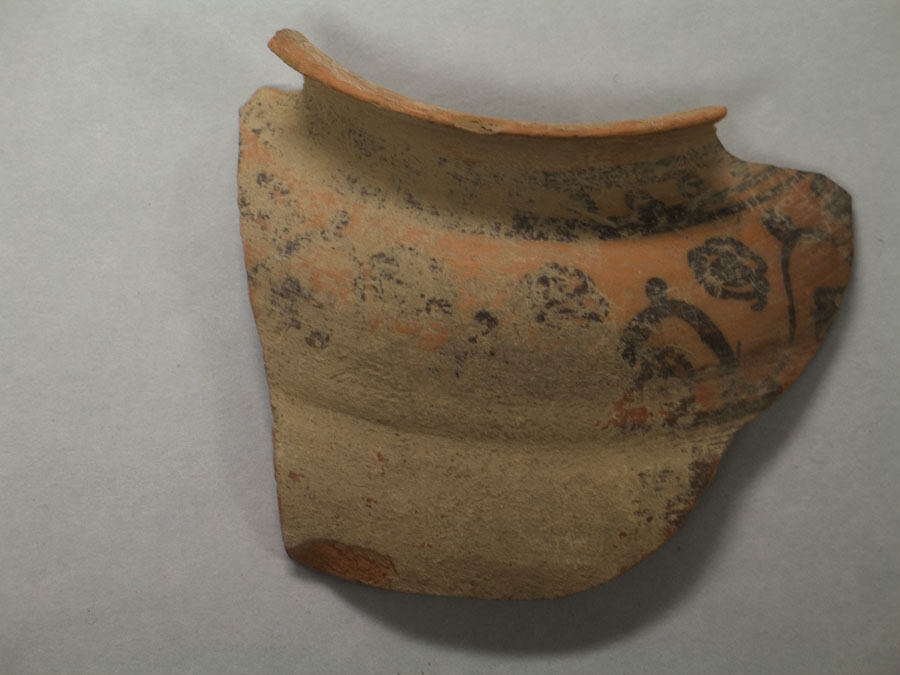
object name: shard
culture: pakistani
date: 301-500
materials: terracotta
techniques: painting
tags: gandhara